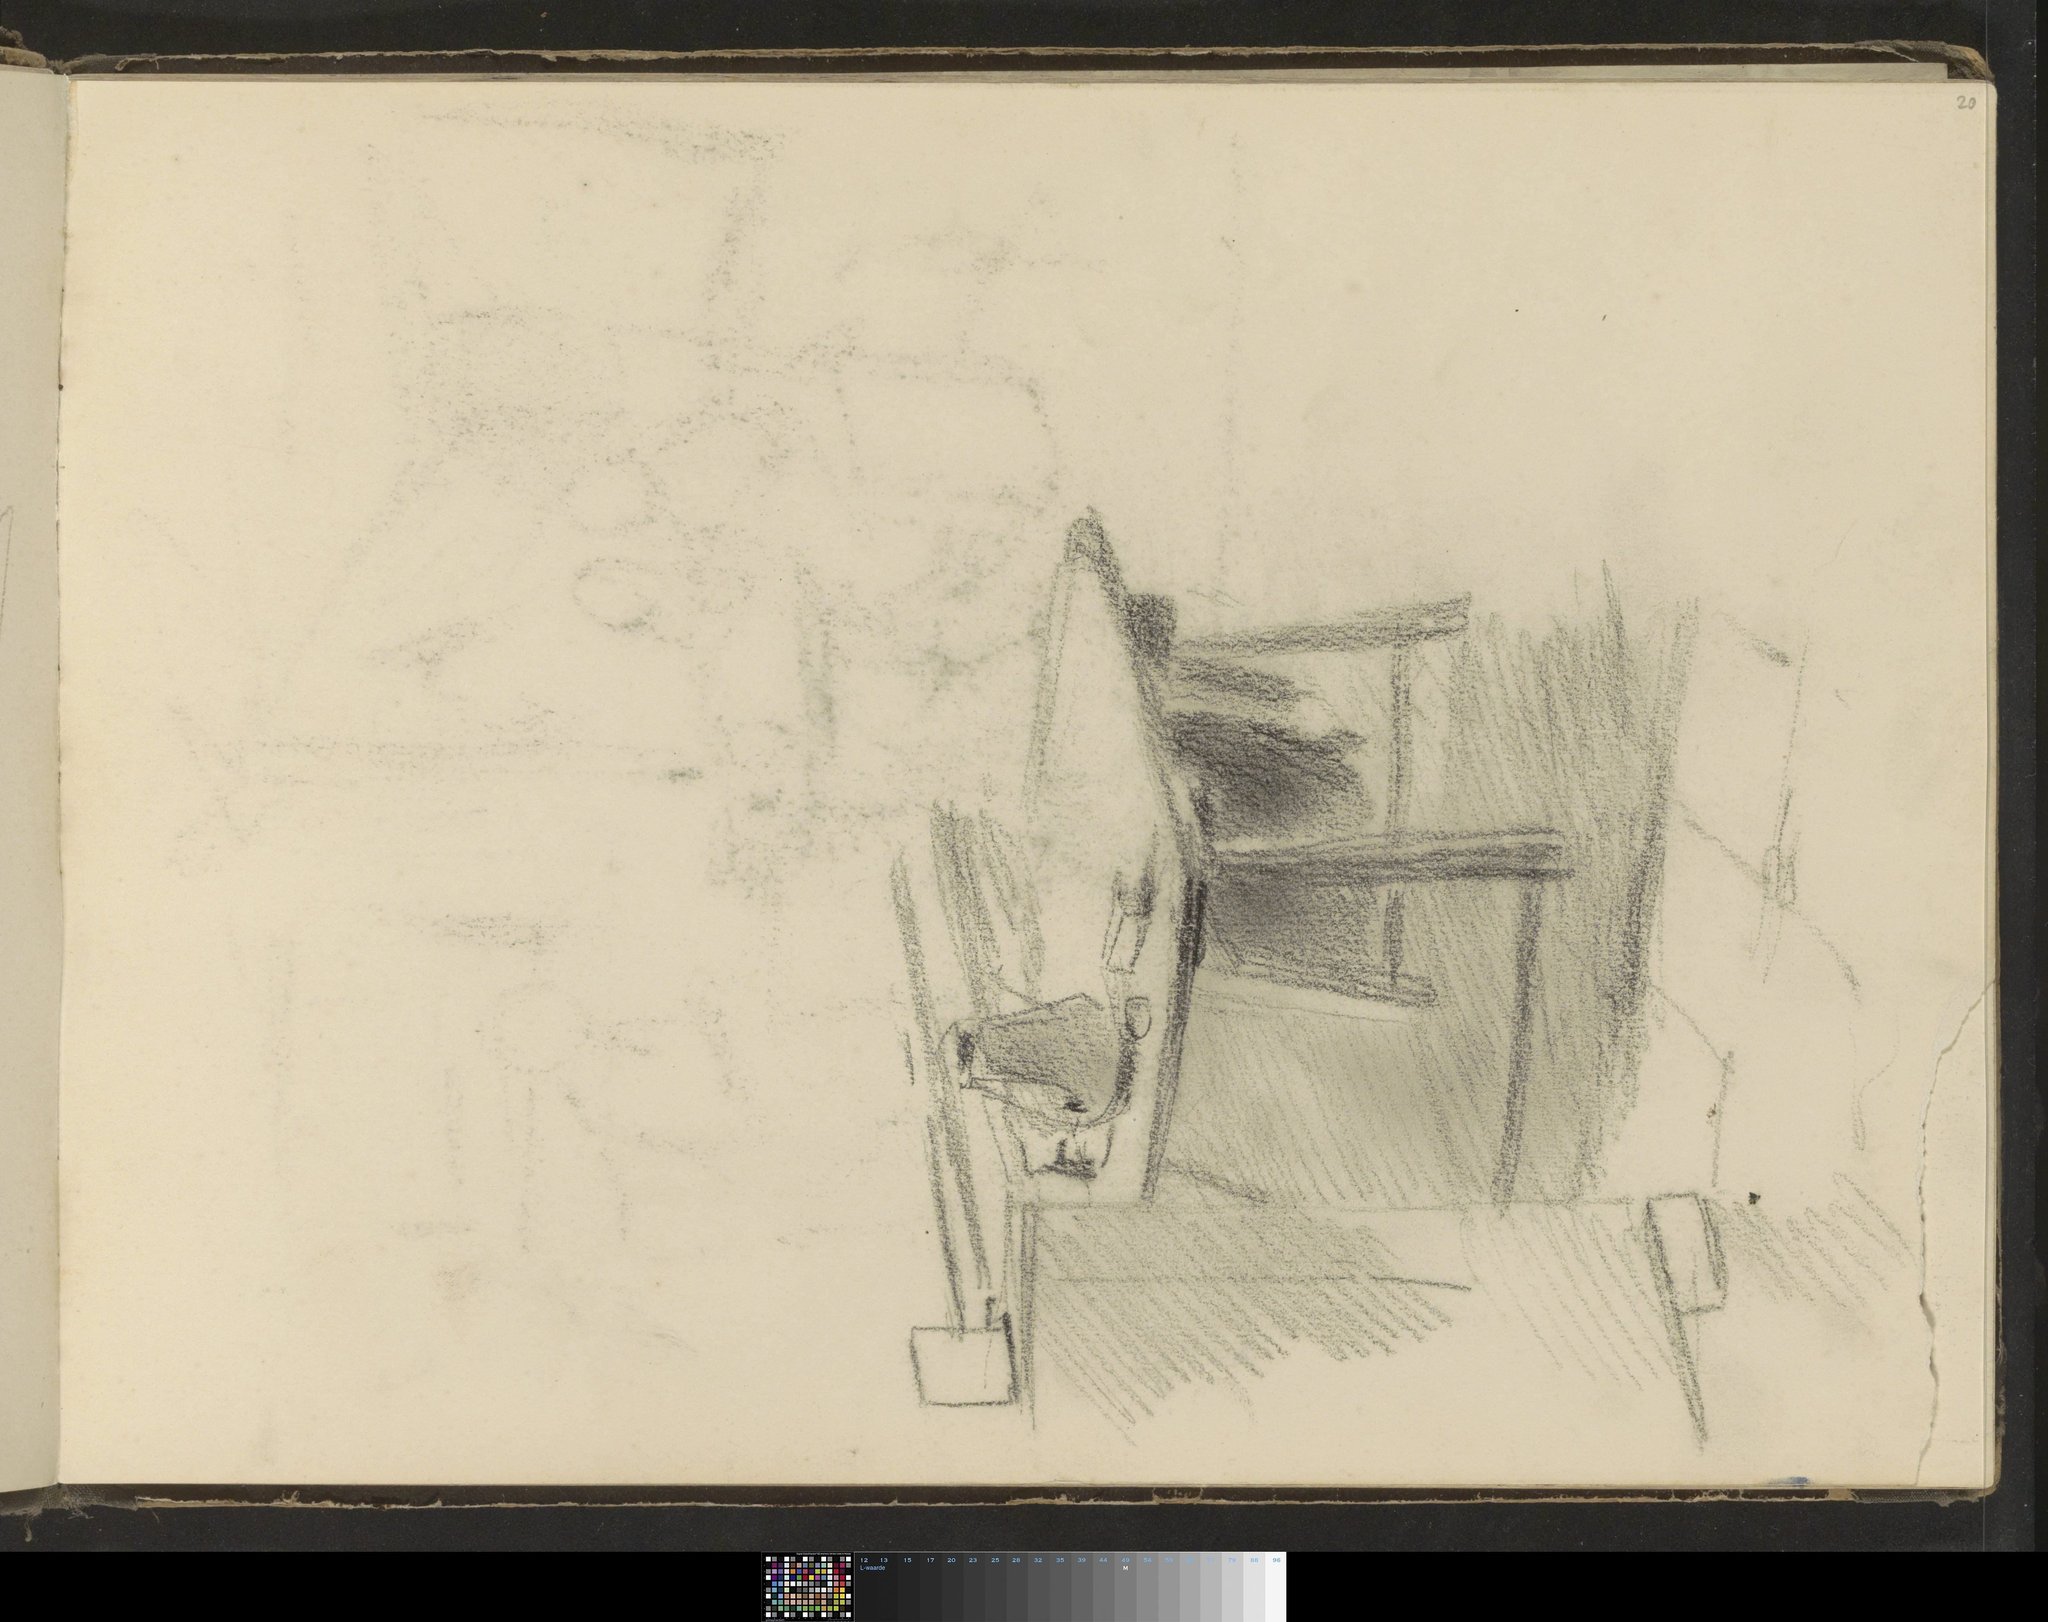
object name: sketchbook leaf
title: Vierkante tafel met een kan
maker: albert neuhuys (1844-1914)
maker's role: draughtsman, painter, print maker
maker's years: 1844-1914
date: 1854-1914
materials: charcoal, paper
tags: jar, jug (used as drinking-vessel), table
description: Blad 20 recto uit een schetsboek met 43 bladen.